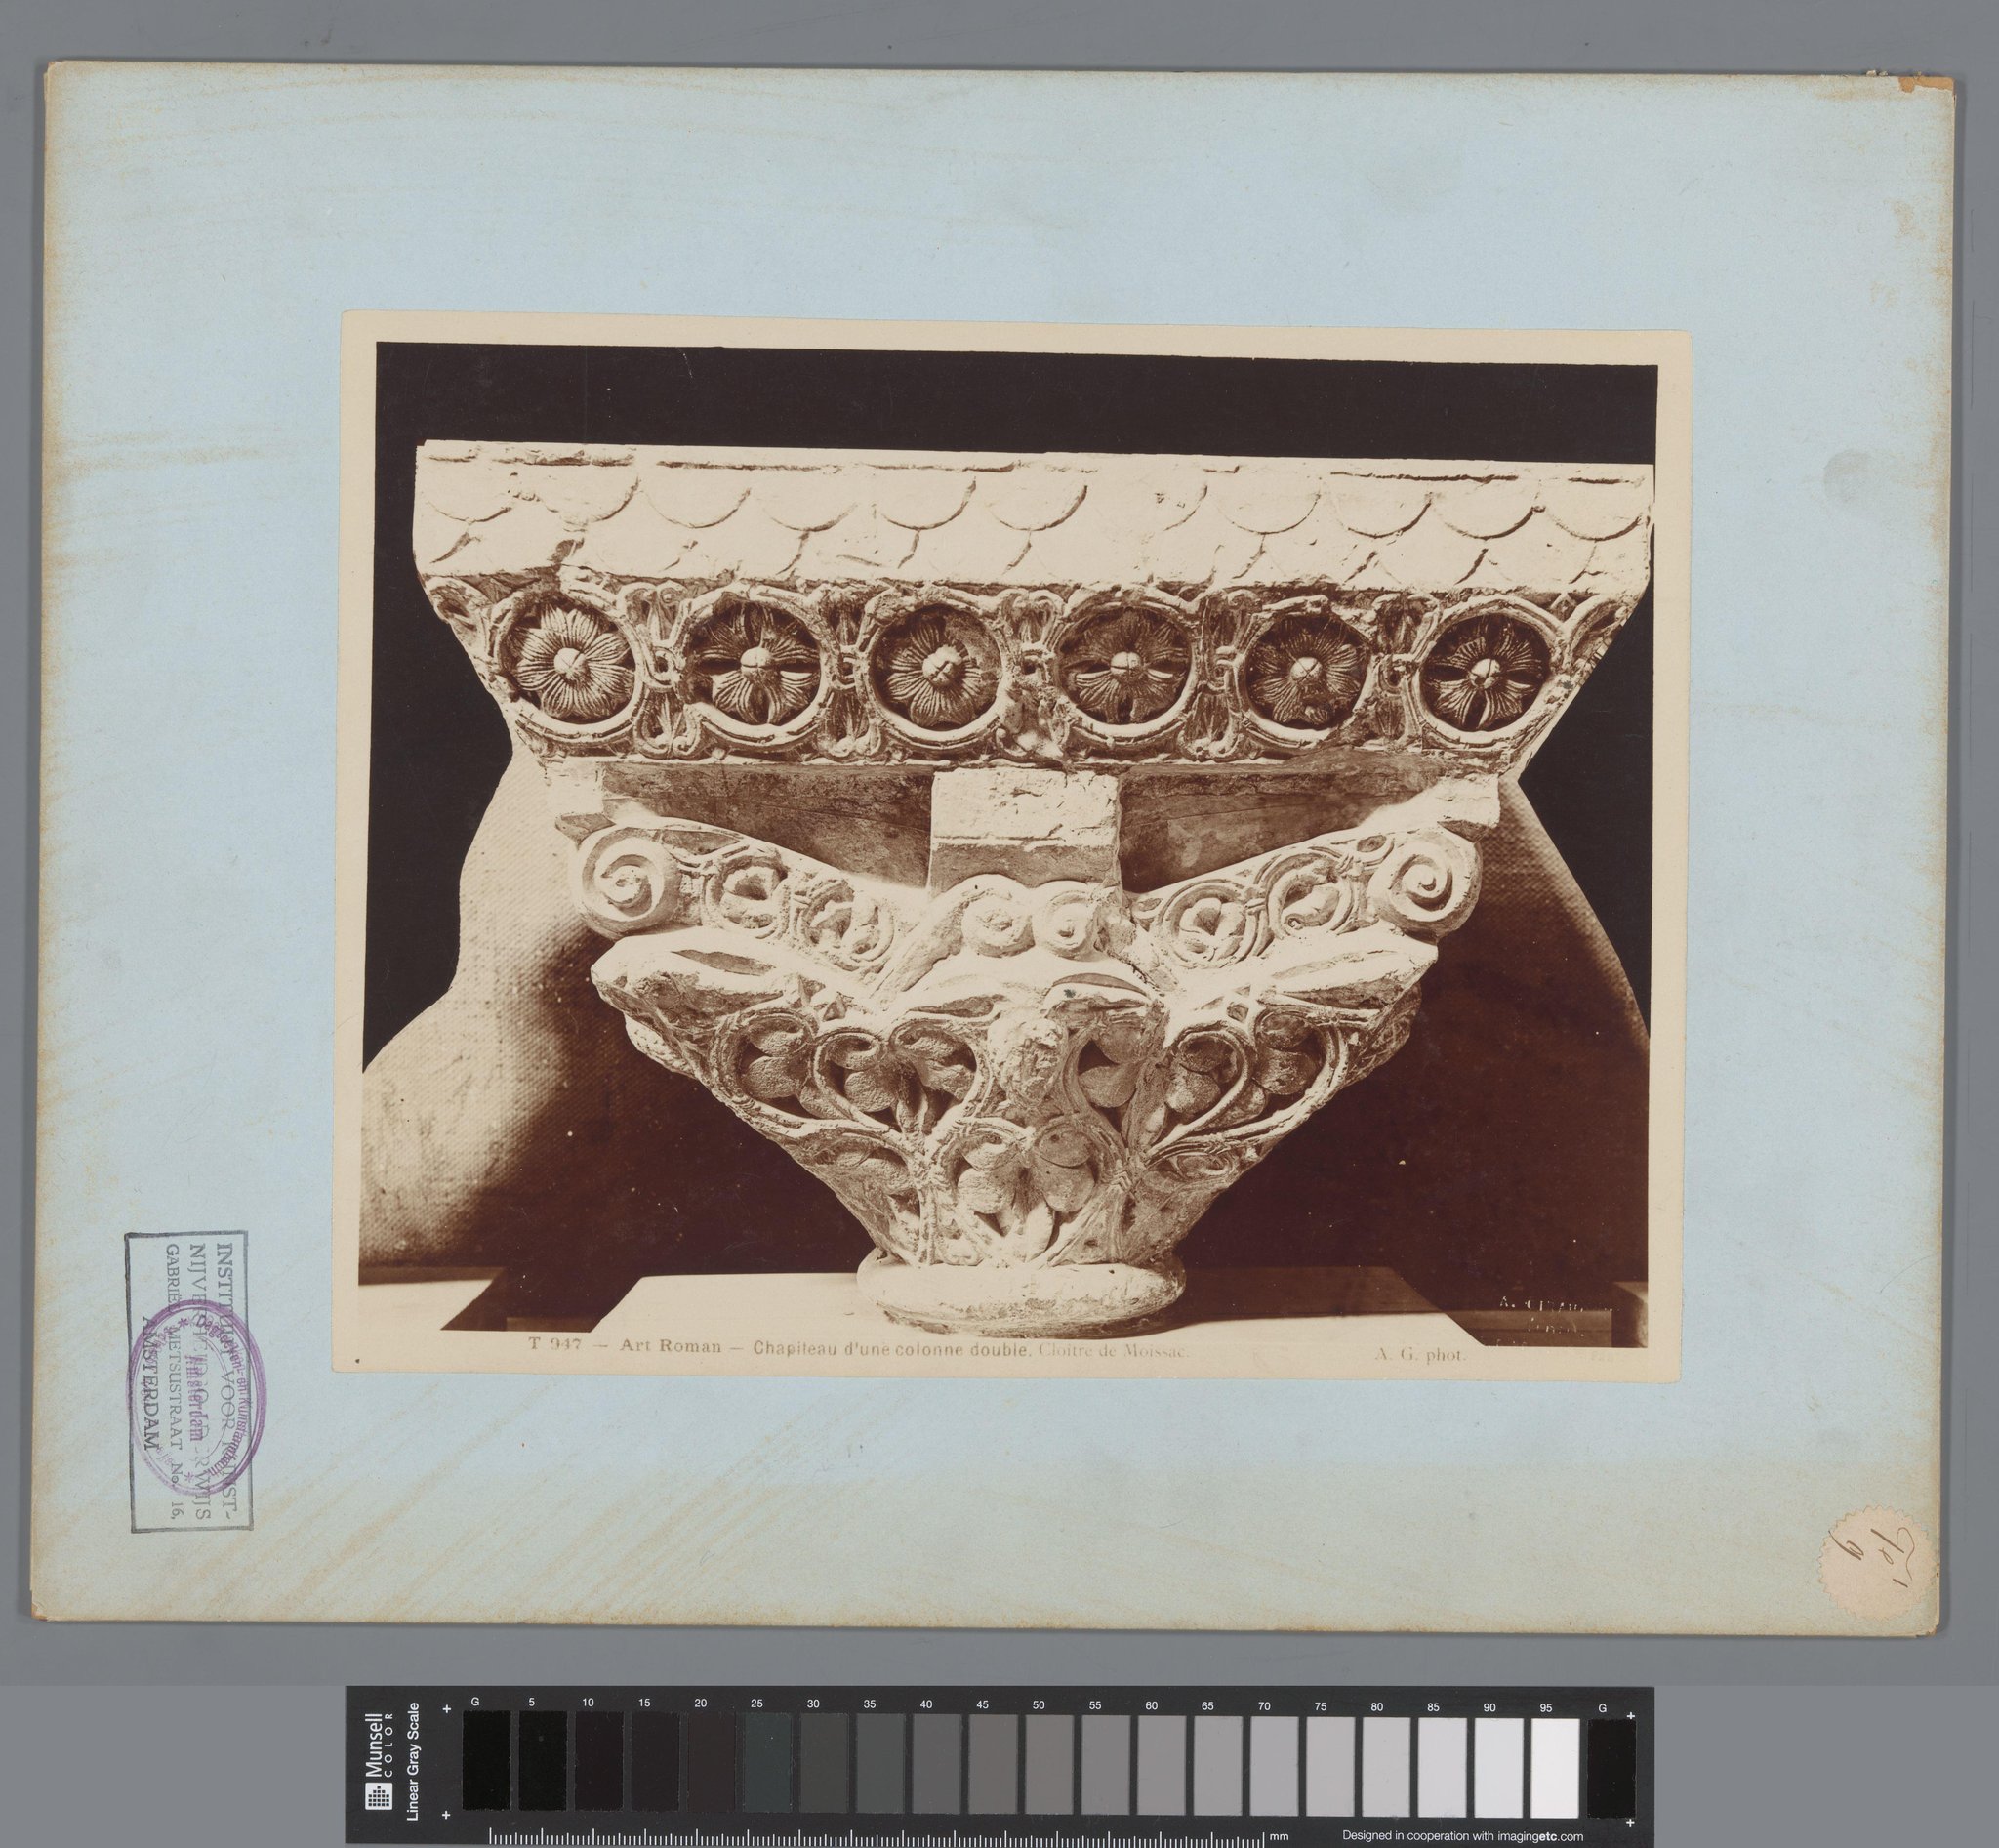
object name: photograph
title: Kapiteel van een dubbelzuil met plantmotieven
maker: adolphe giraudon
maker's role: publisher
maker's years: 1849-1929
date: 1875-1900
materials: cardboard, photographic support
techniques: albumen print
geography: paris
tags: capital (~ column, pillar), foliage, tendrils, branches ~ ornament, flowers ~ ornament, sculpture (+ relief ~ sculpture)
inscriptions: number: ‘T 947’, name: ‘A. GIRAUDON ÉDITEUR 15. R. BONAPARTE. PARIS’, collector's mark: ‘INSTITUUT VOOR KUNST-NIJVERHEIDSONDERWIJS GABRIËL METSUSTRAAT No. 16, AMSTERDAM’, collector's mark: ‘Dagteeken- en Kunstambacht- school voor Meisjes Amsterdam’